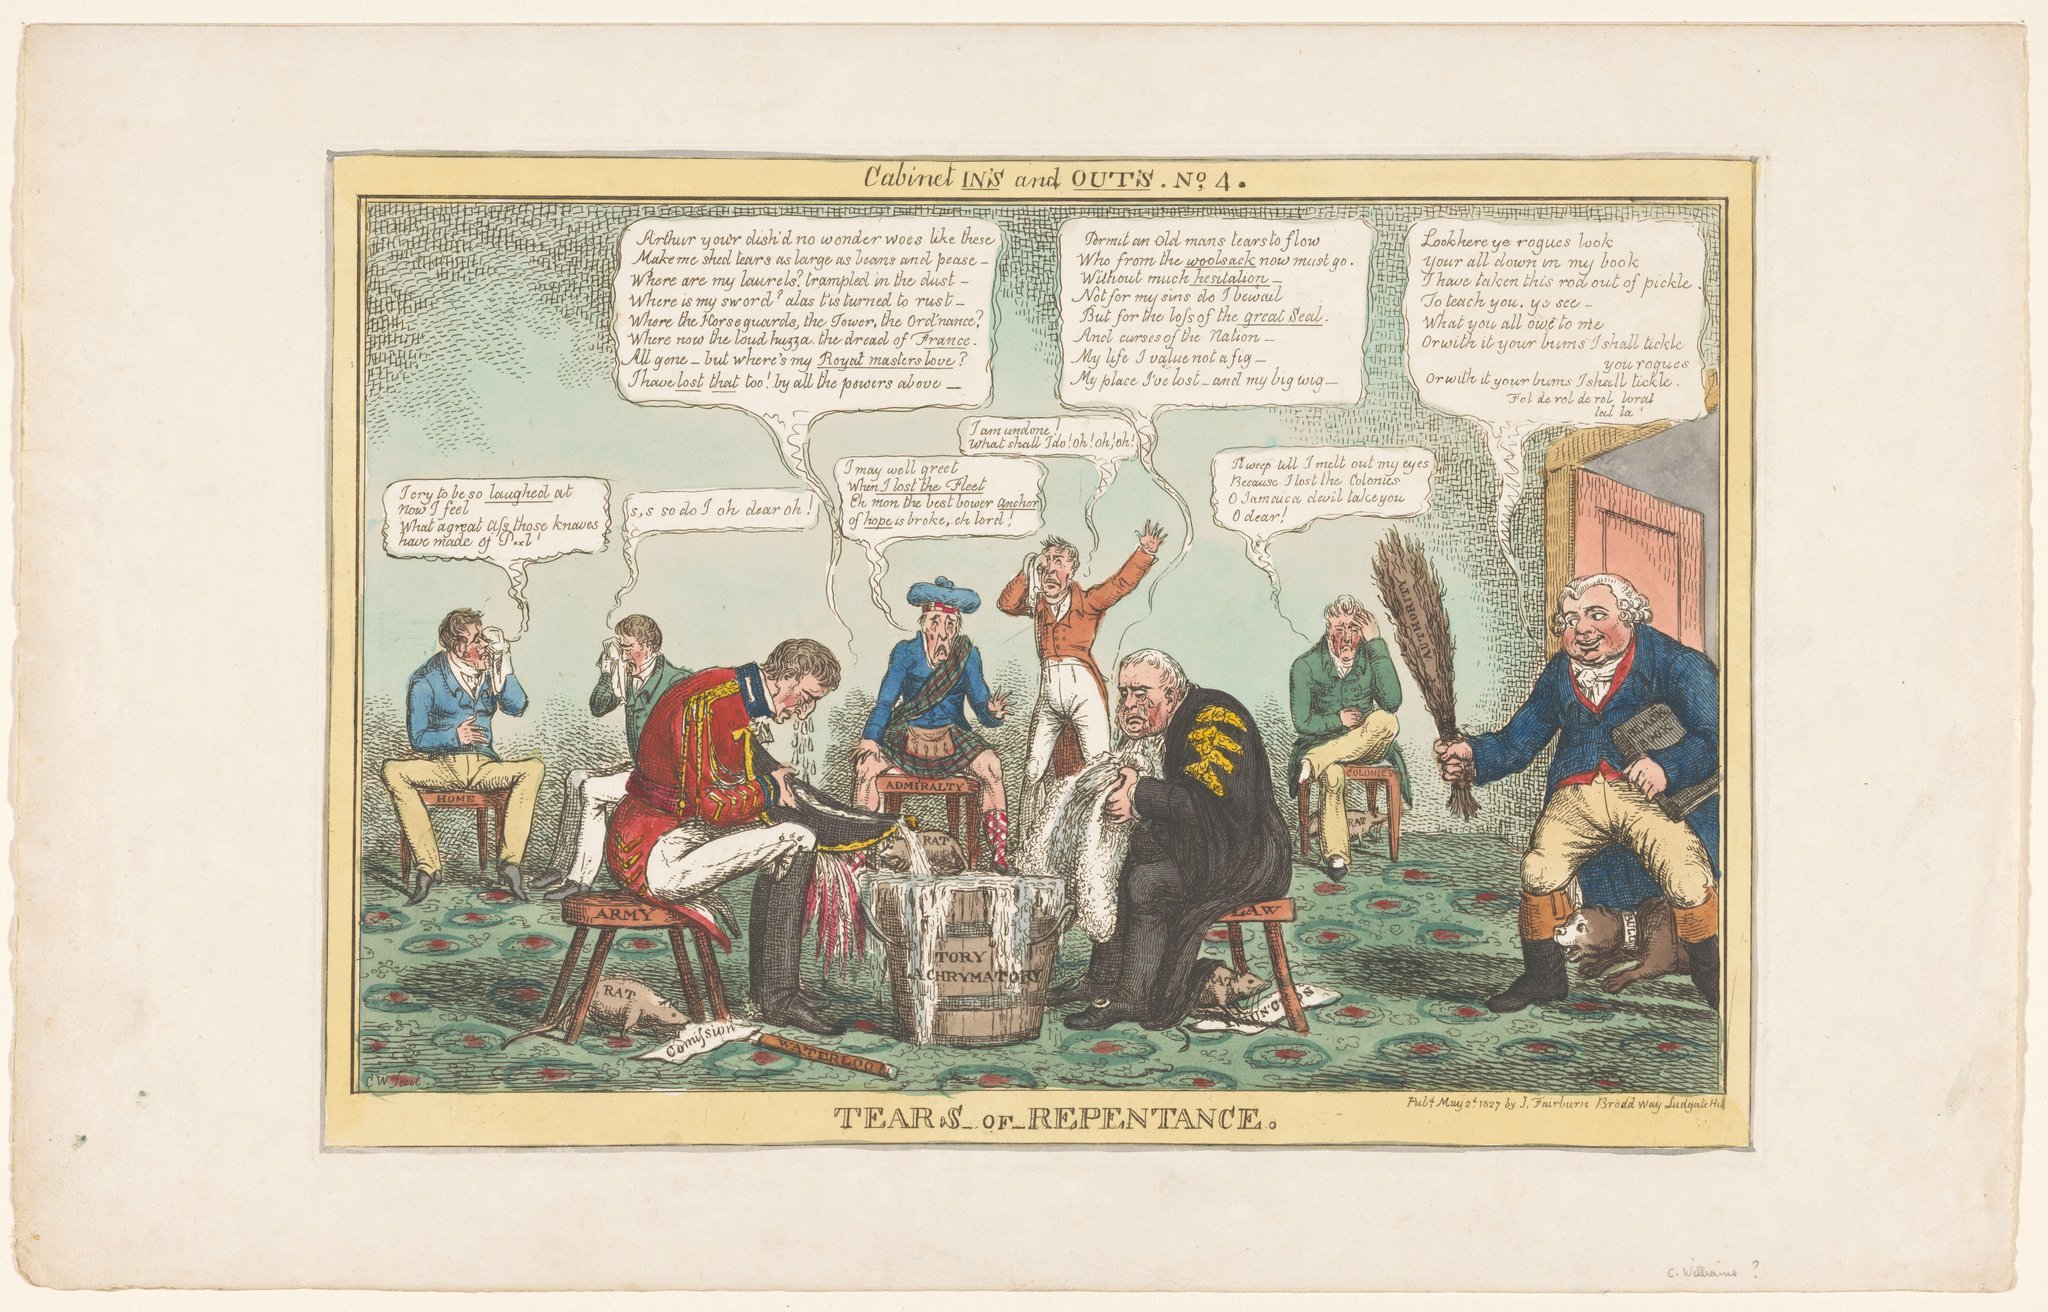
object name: cartoon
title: Tears of Repentance / Cabinet In's and Out's. No. 4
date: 1827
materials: paper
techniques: etching, hand coloring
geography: london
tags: london, politician, walmer castle, arthur wellesley of wellington, personifications of countries, nations, states, districts, etc., weeping, political caricatures and satires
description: Spotprent op de Hertog van Wellington en de Lord Chancellor (John Scott, 1st Earl of Eldon) die een houten emmer vol huilen met hun tranen. Rechts bij de deur John Bull met een takkenbos. Op de achtergrond meerdere huilende mensen.